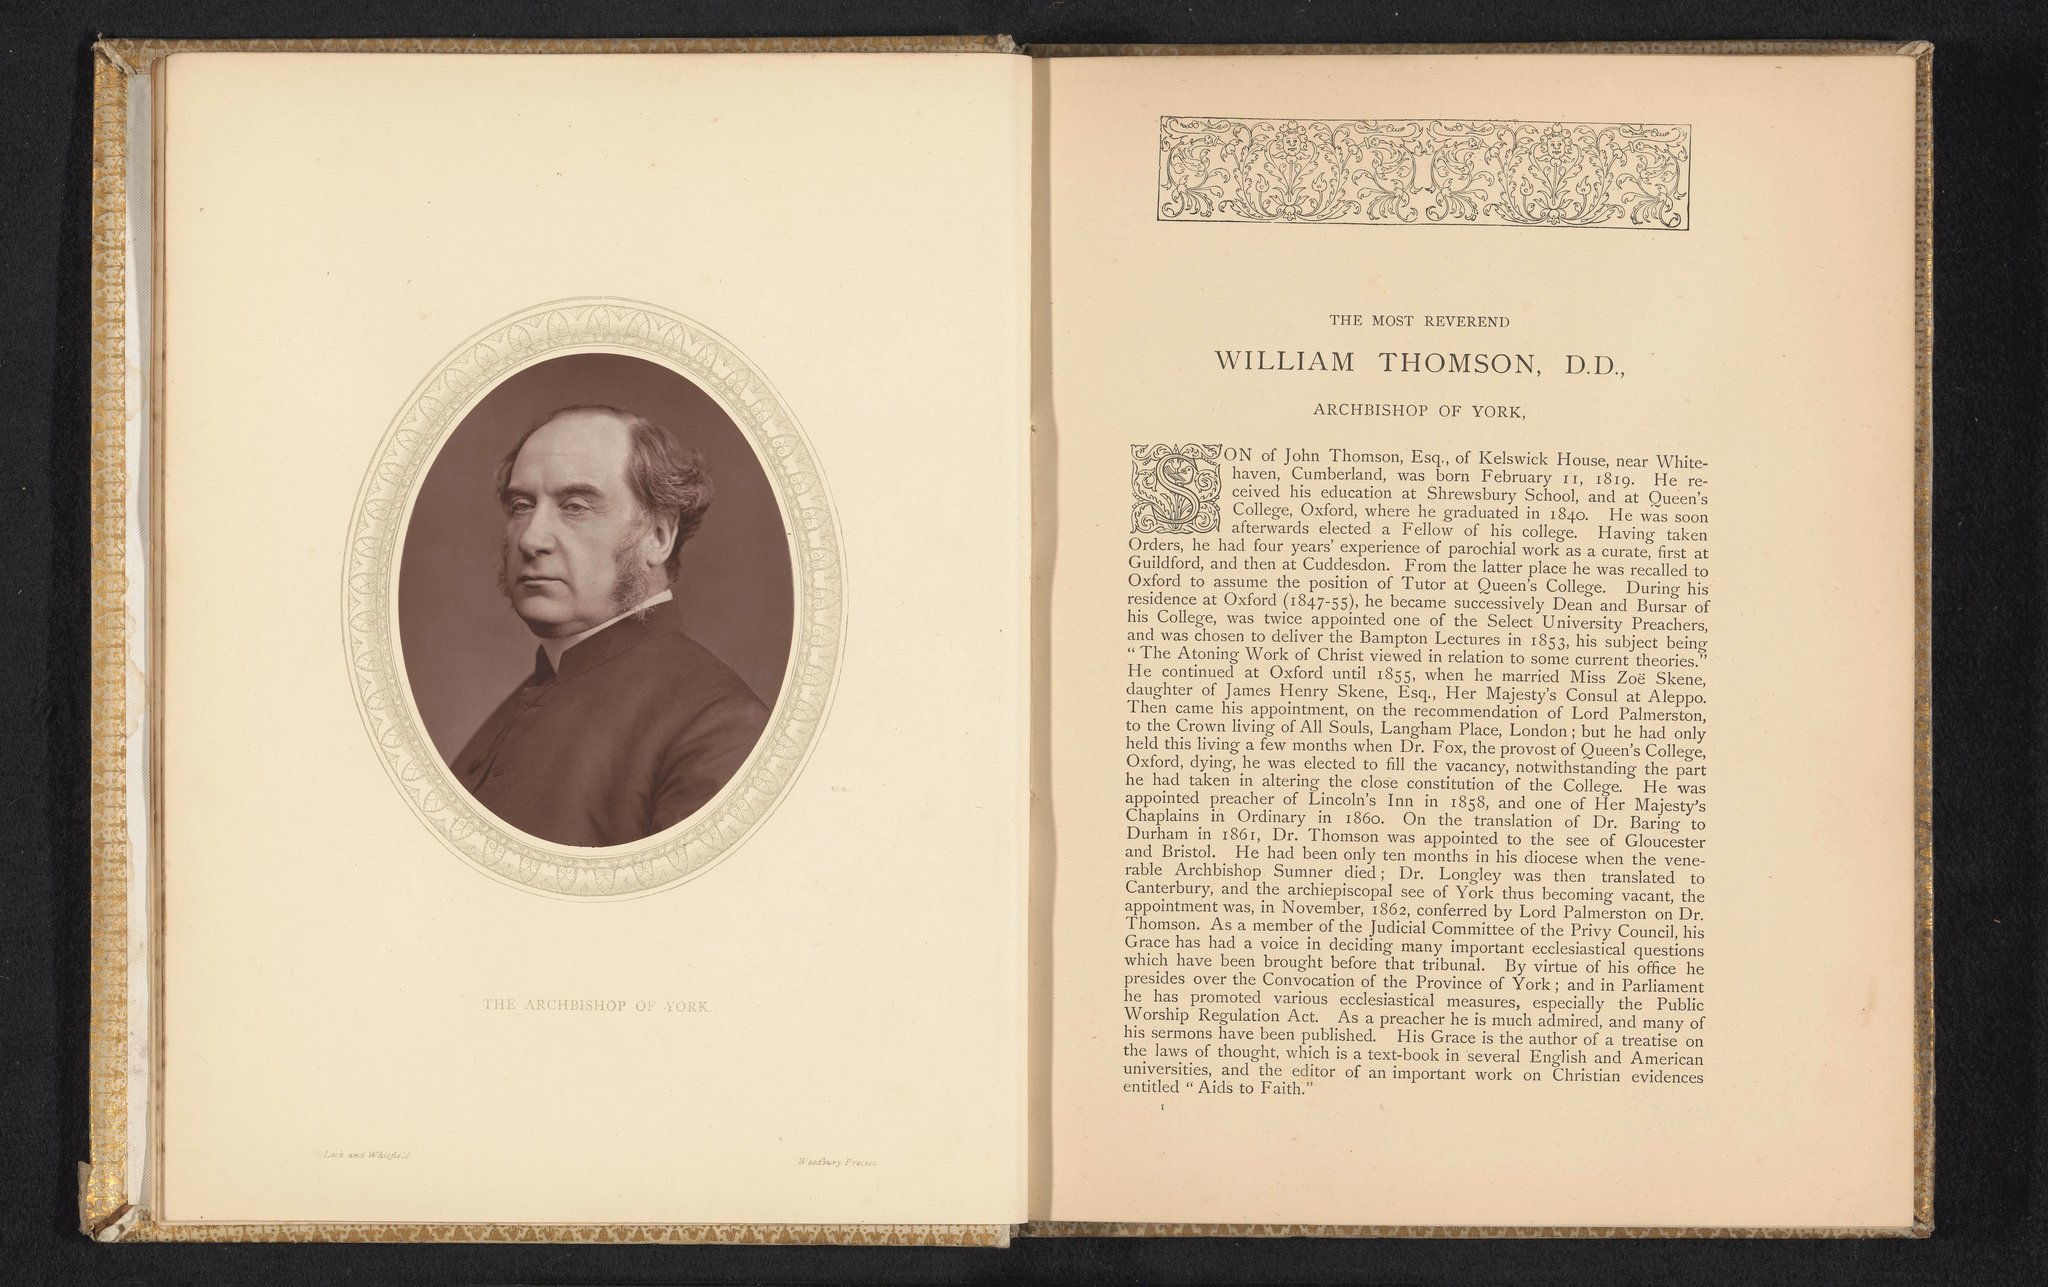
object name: photomechanical print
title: The archbishop of York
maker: Anonymous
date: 1873-1878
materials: paper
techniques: woodburytype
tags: archbishop, bishop, etc. (roman catholic), historical persons (portraits and scenes from the life) (+ (full) bust portrait)